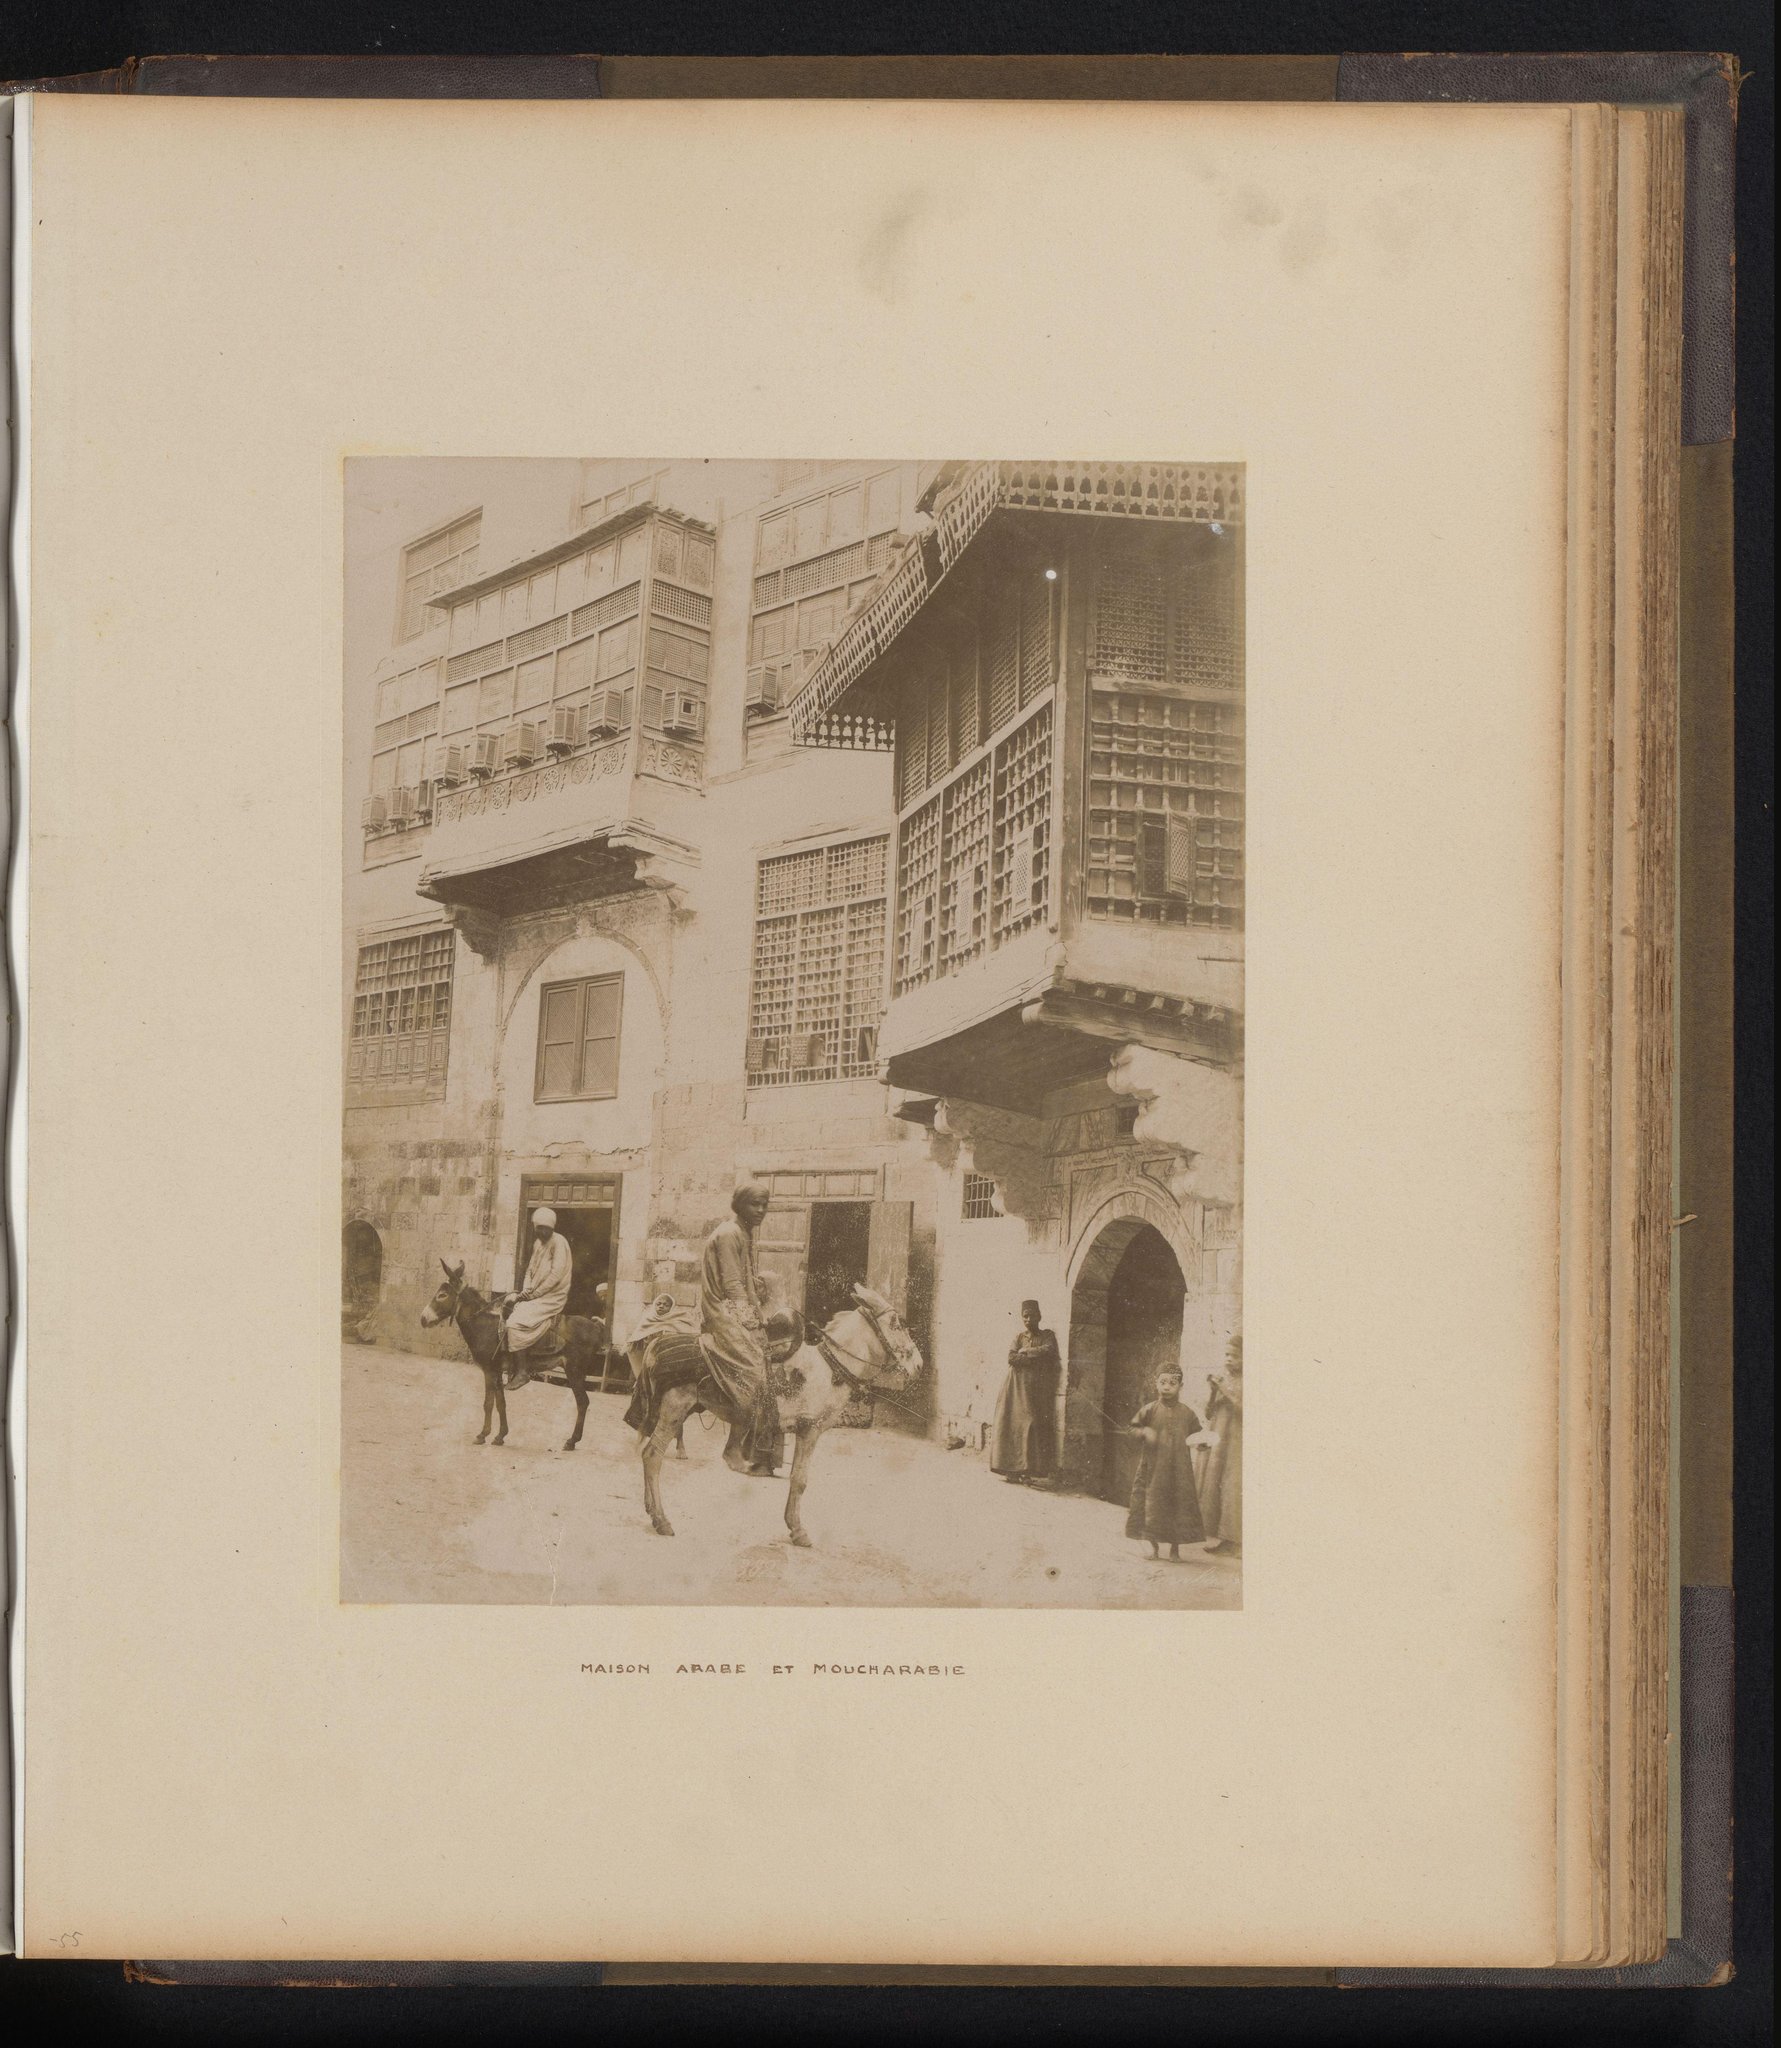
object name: photograph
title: Huis met mashrabiya in Jeruzalem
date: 1870-1910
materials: paper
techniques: albumen print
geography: jerusalem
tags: urban housing